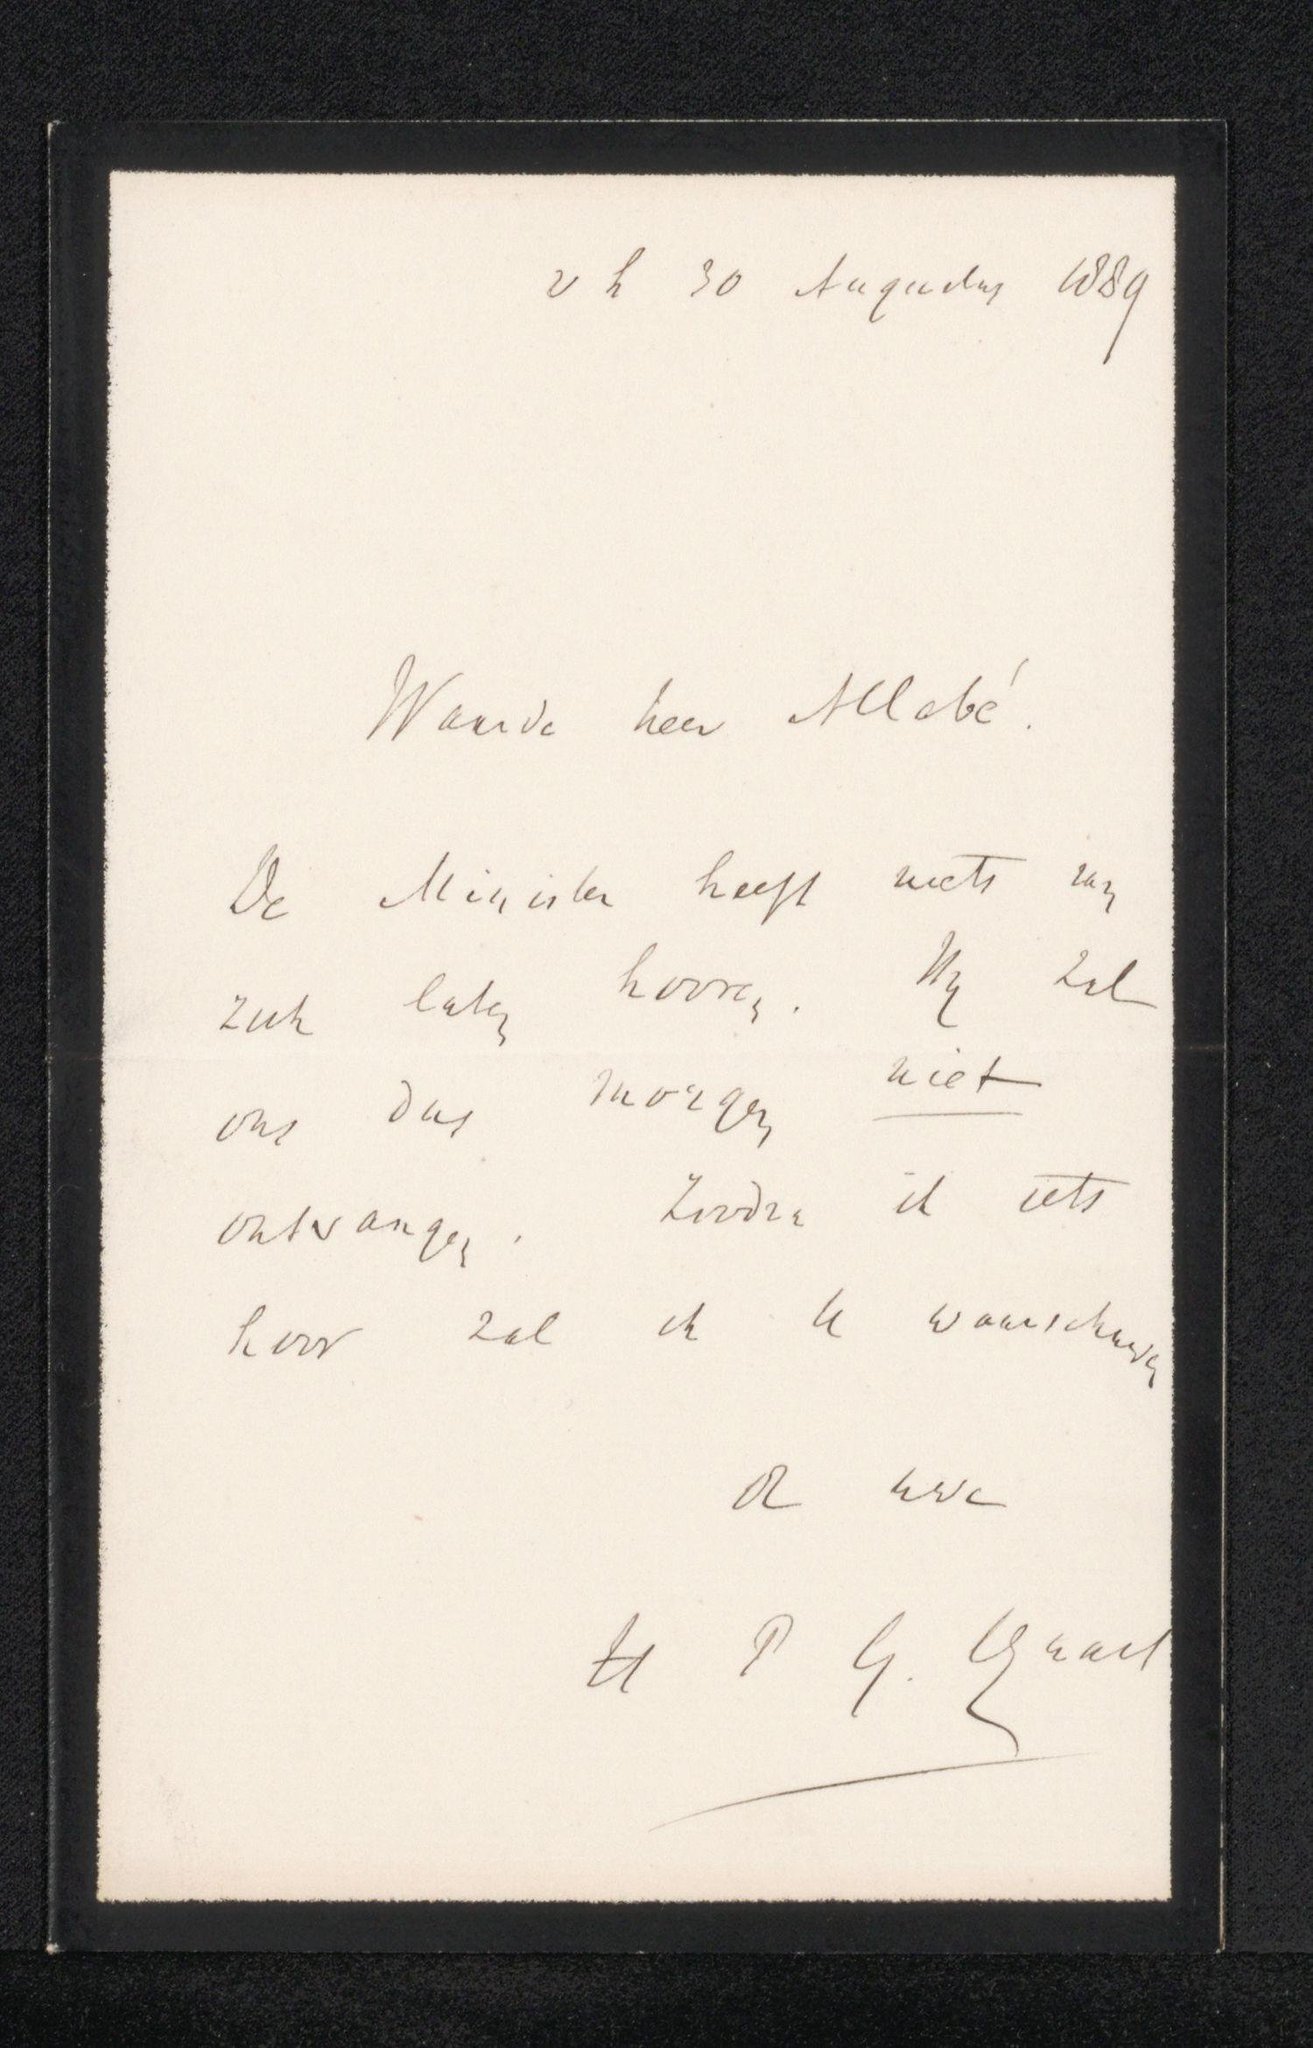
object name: letter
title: Brief aan August Allebé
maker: hendrick peter godfried quack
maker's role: econoom, geschiedschrijver, hoogleraar, jurist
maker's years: 1834-1917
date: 1889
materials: ink, paper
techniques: pen, writing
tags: amsterdam, draughtsman, august allebé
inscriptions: watermark